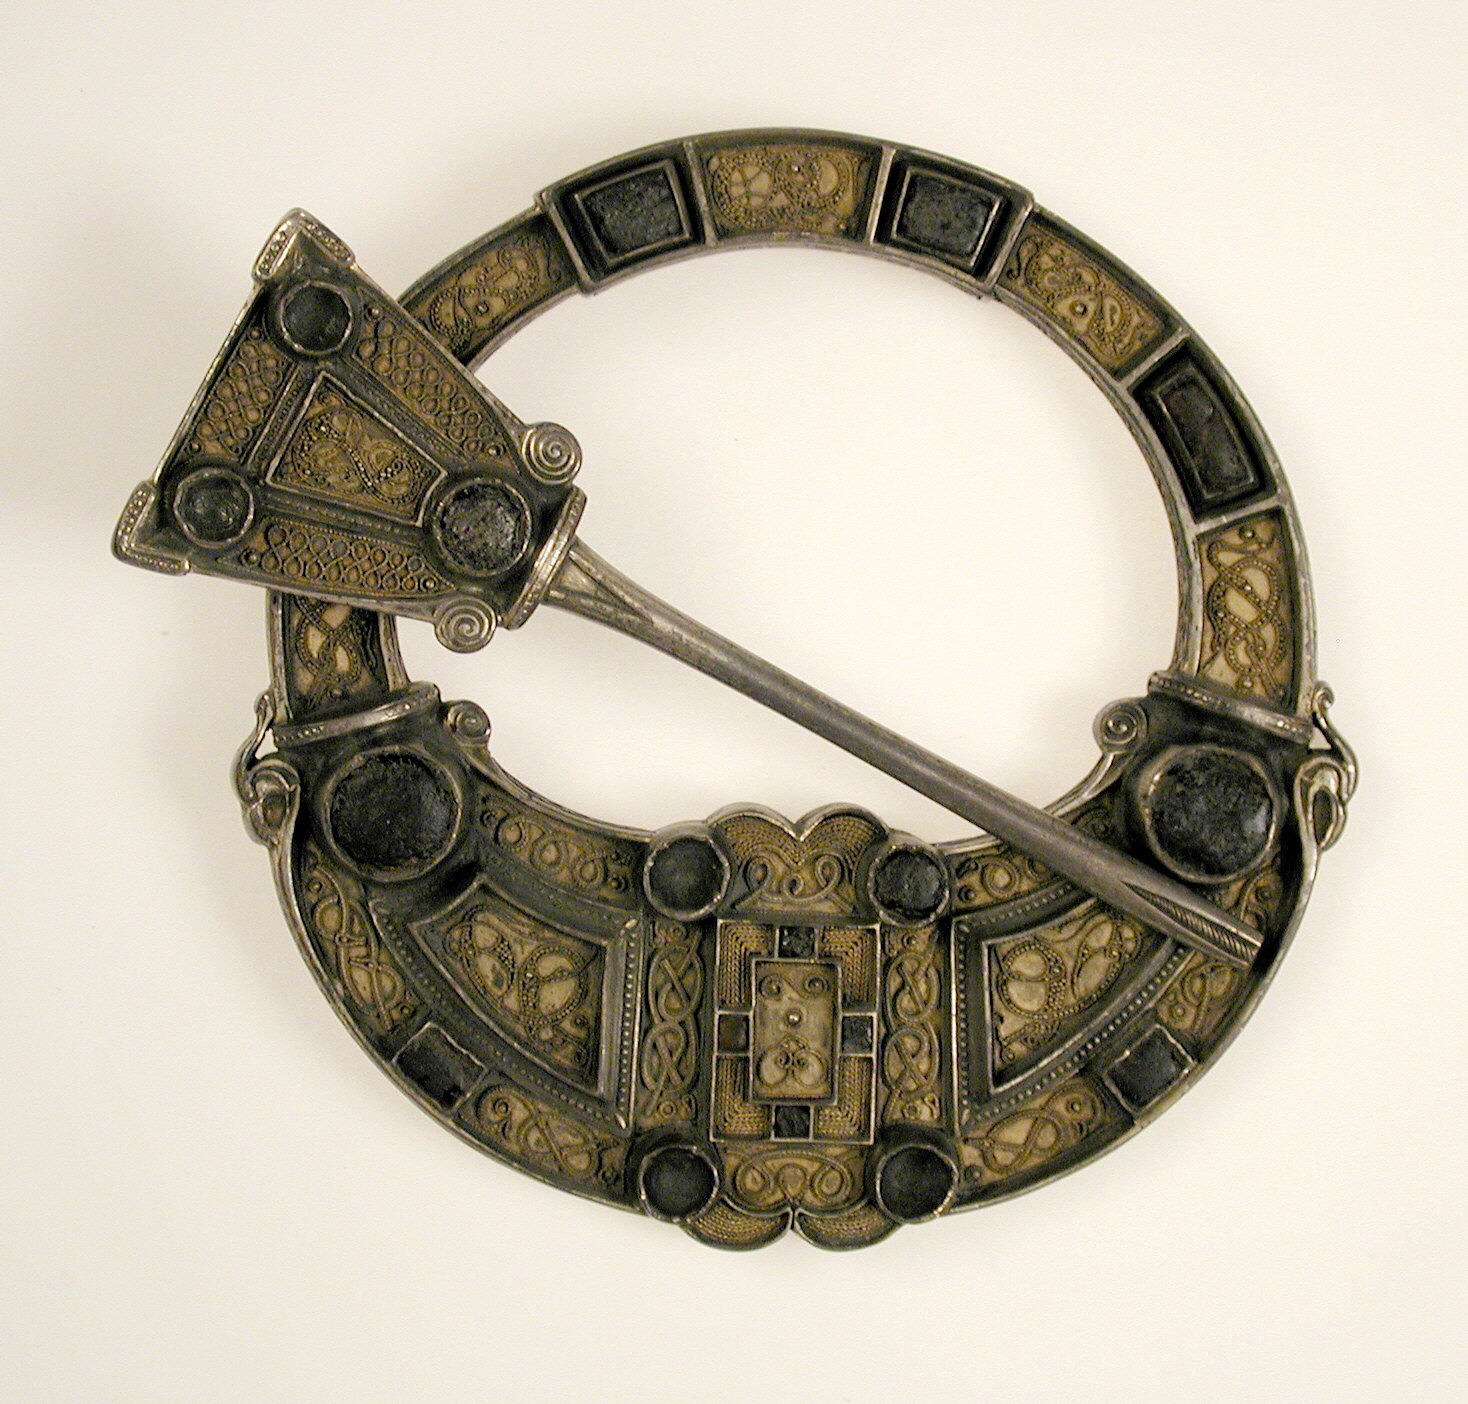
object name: brooch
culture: scottish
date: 1901-1933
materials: glass, silver gilt